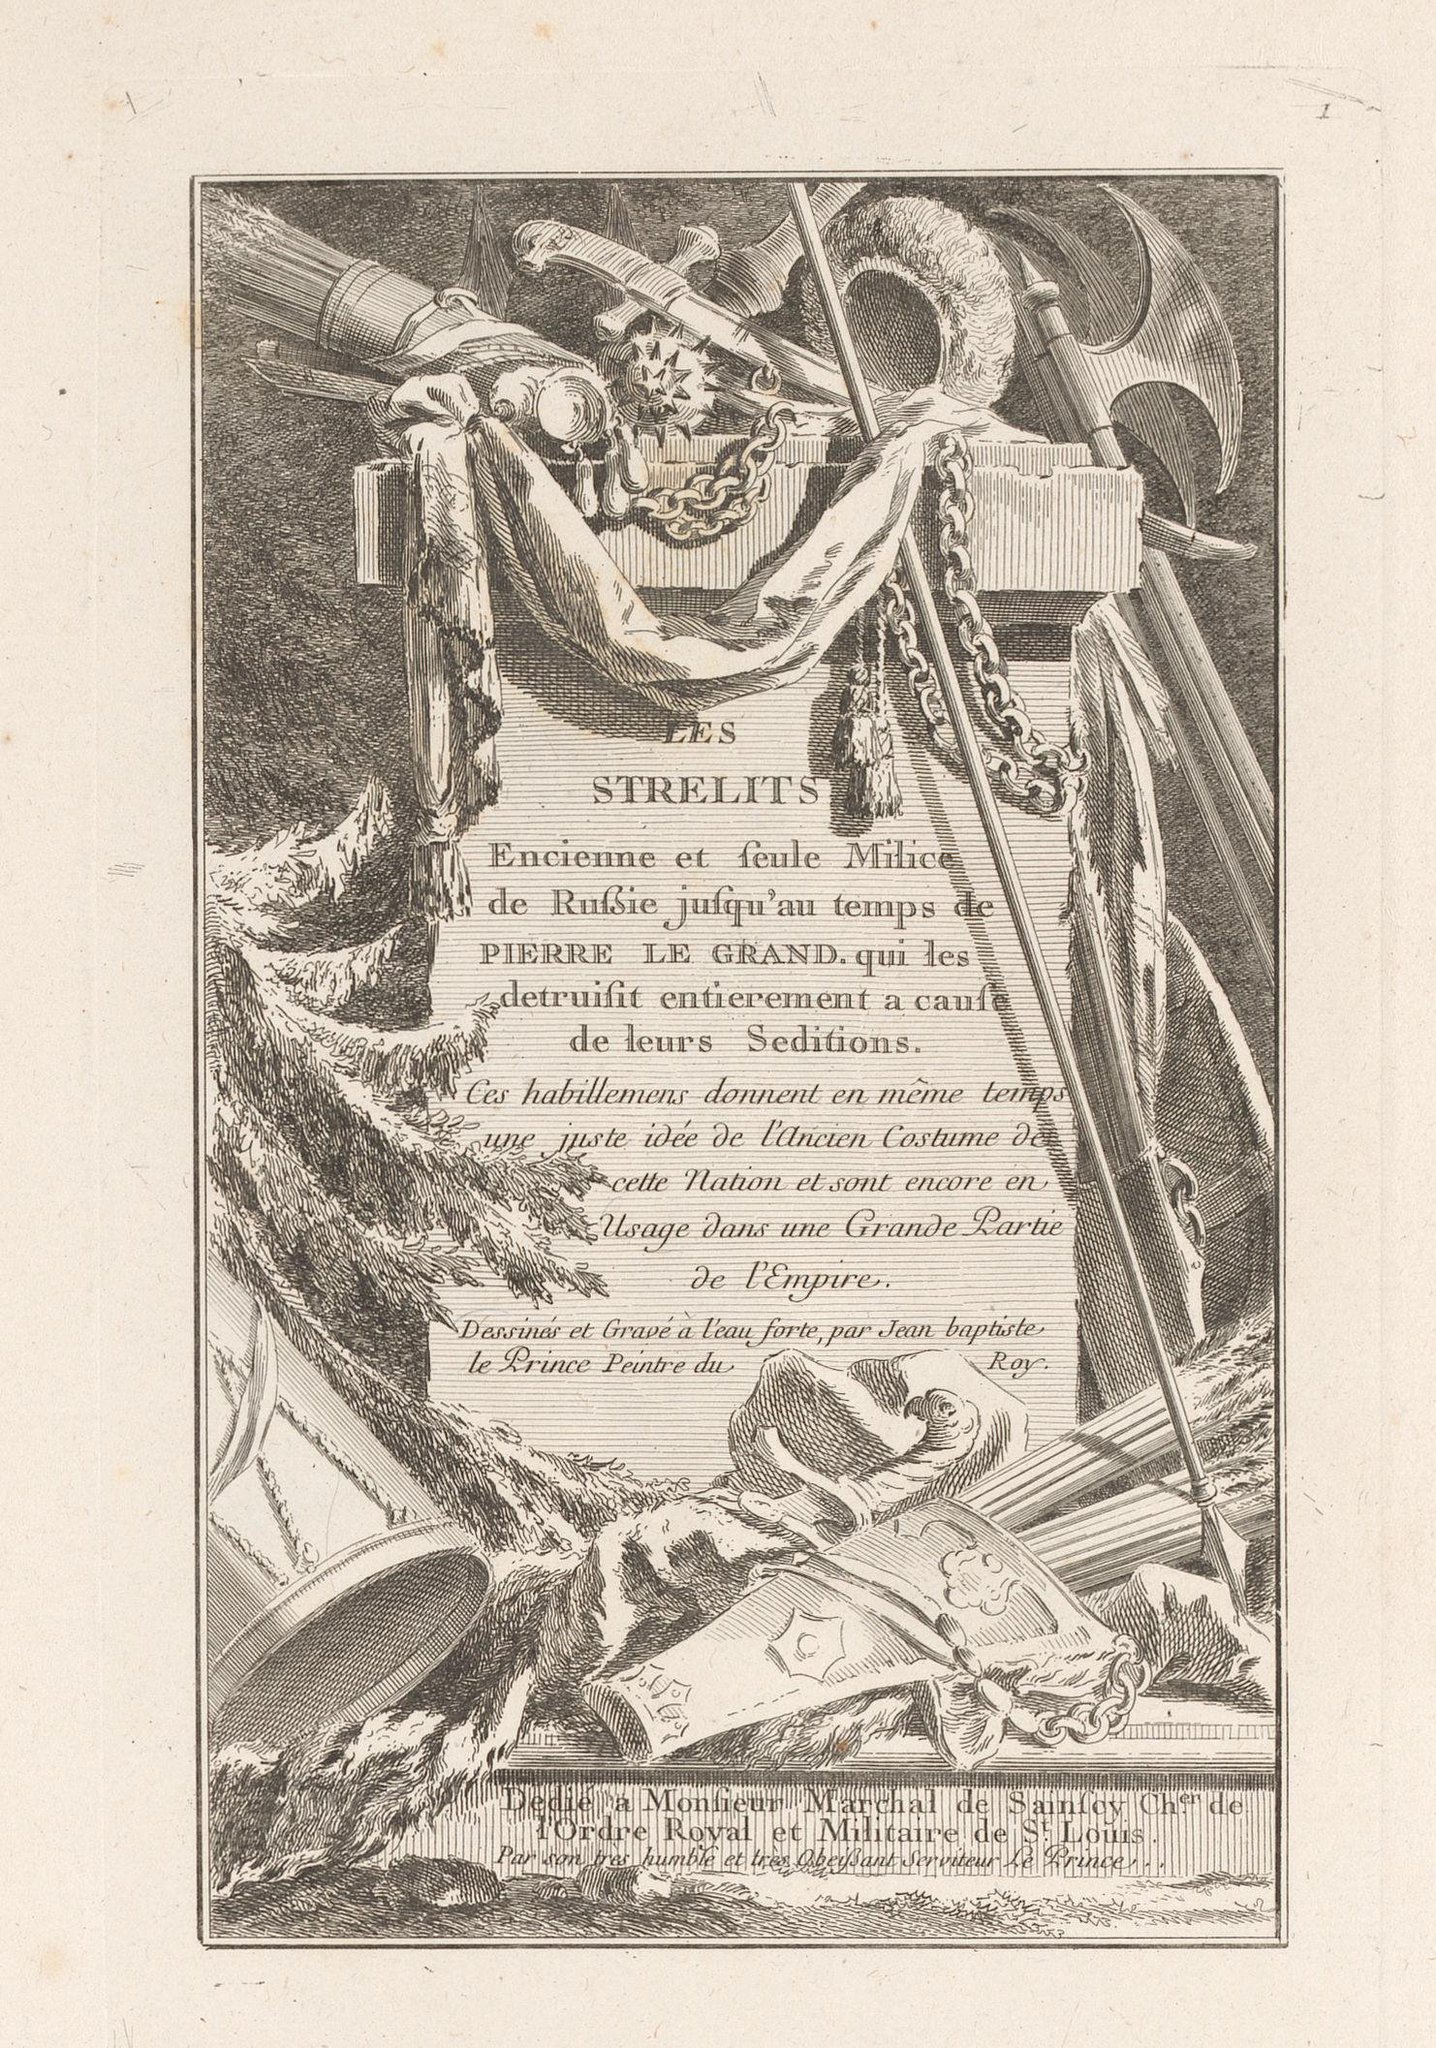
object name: album leaf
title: Soldaten uit de eenheid Strelitsen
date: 1764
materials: paper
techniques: etching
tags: land forces, firearms